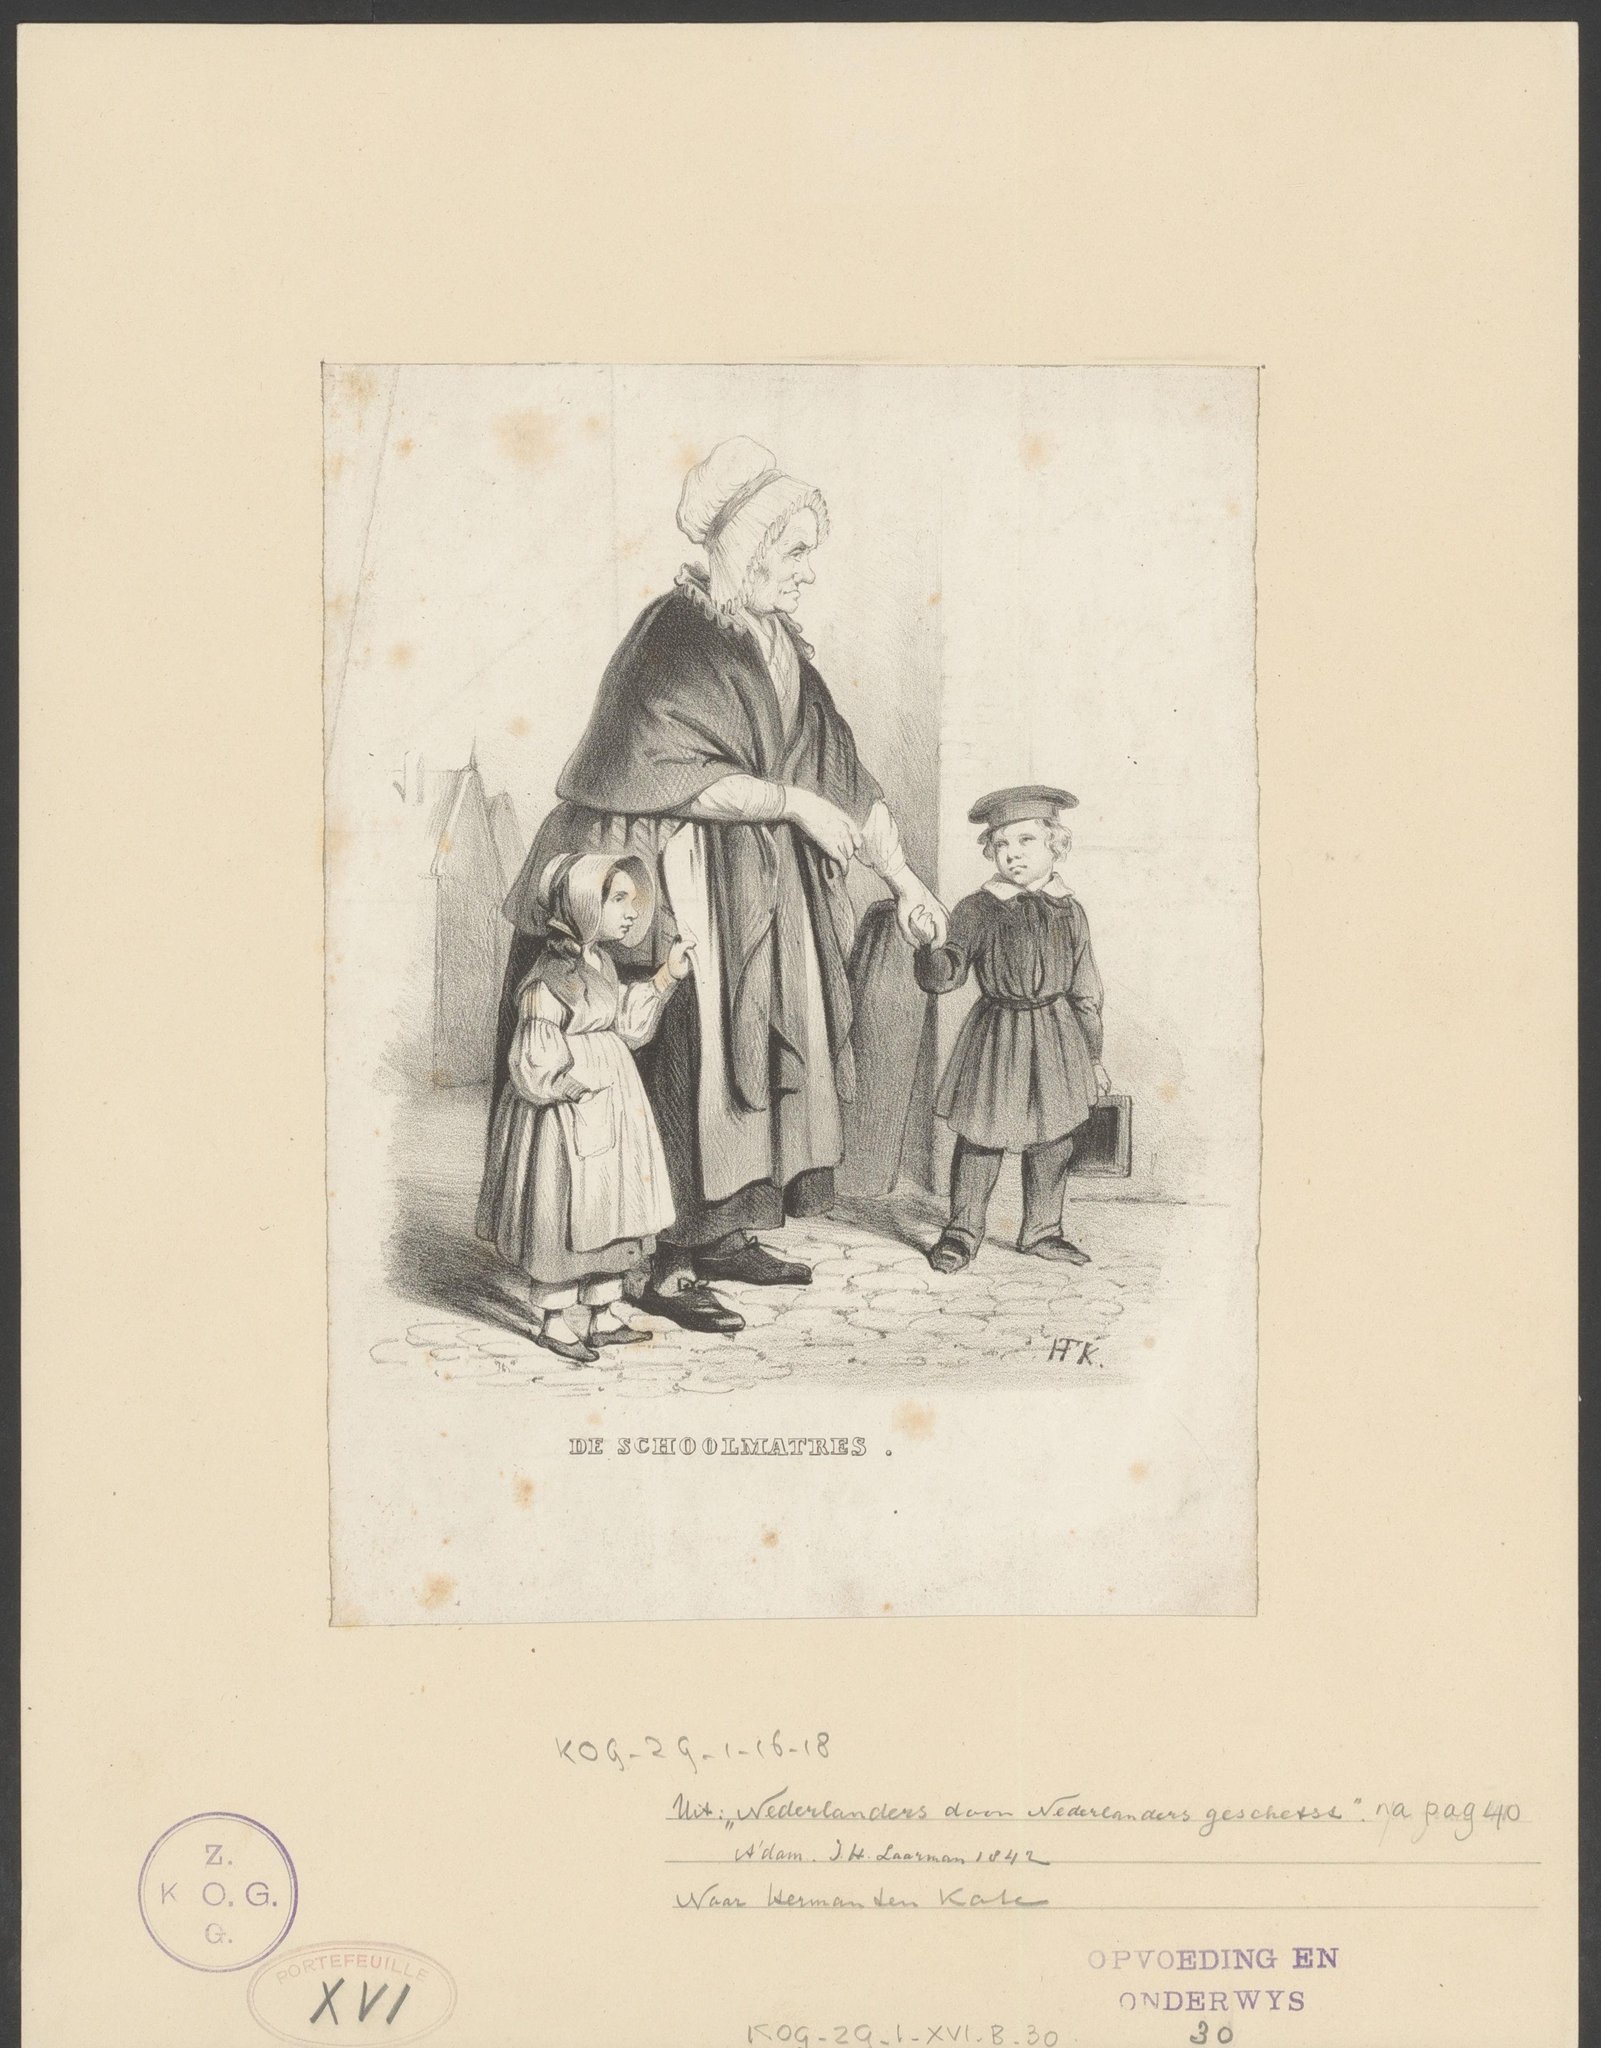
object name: print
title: Schoolmatres van de kleinkinderschool met twee kinderen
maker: herman frederik carel ten kate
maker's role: draughtsman, painter, print maker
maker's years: 1822-1891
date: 1842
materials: paper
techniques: lithograph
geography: the hague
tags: scholar, philosopher, pipe ~ tobacco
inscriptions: collector's mark: Lugt 1641, stamp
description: Onderwerpsrubrieken binnen de Atlas Zeden en Gewoonten: Onderwijs en Wetenschappen, Opvoeding en Onderwijs, Schoolmeesters.